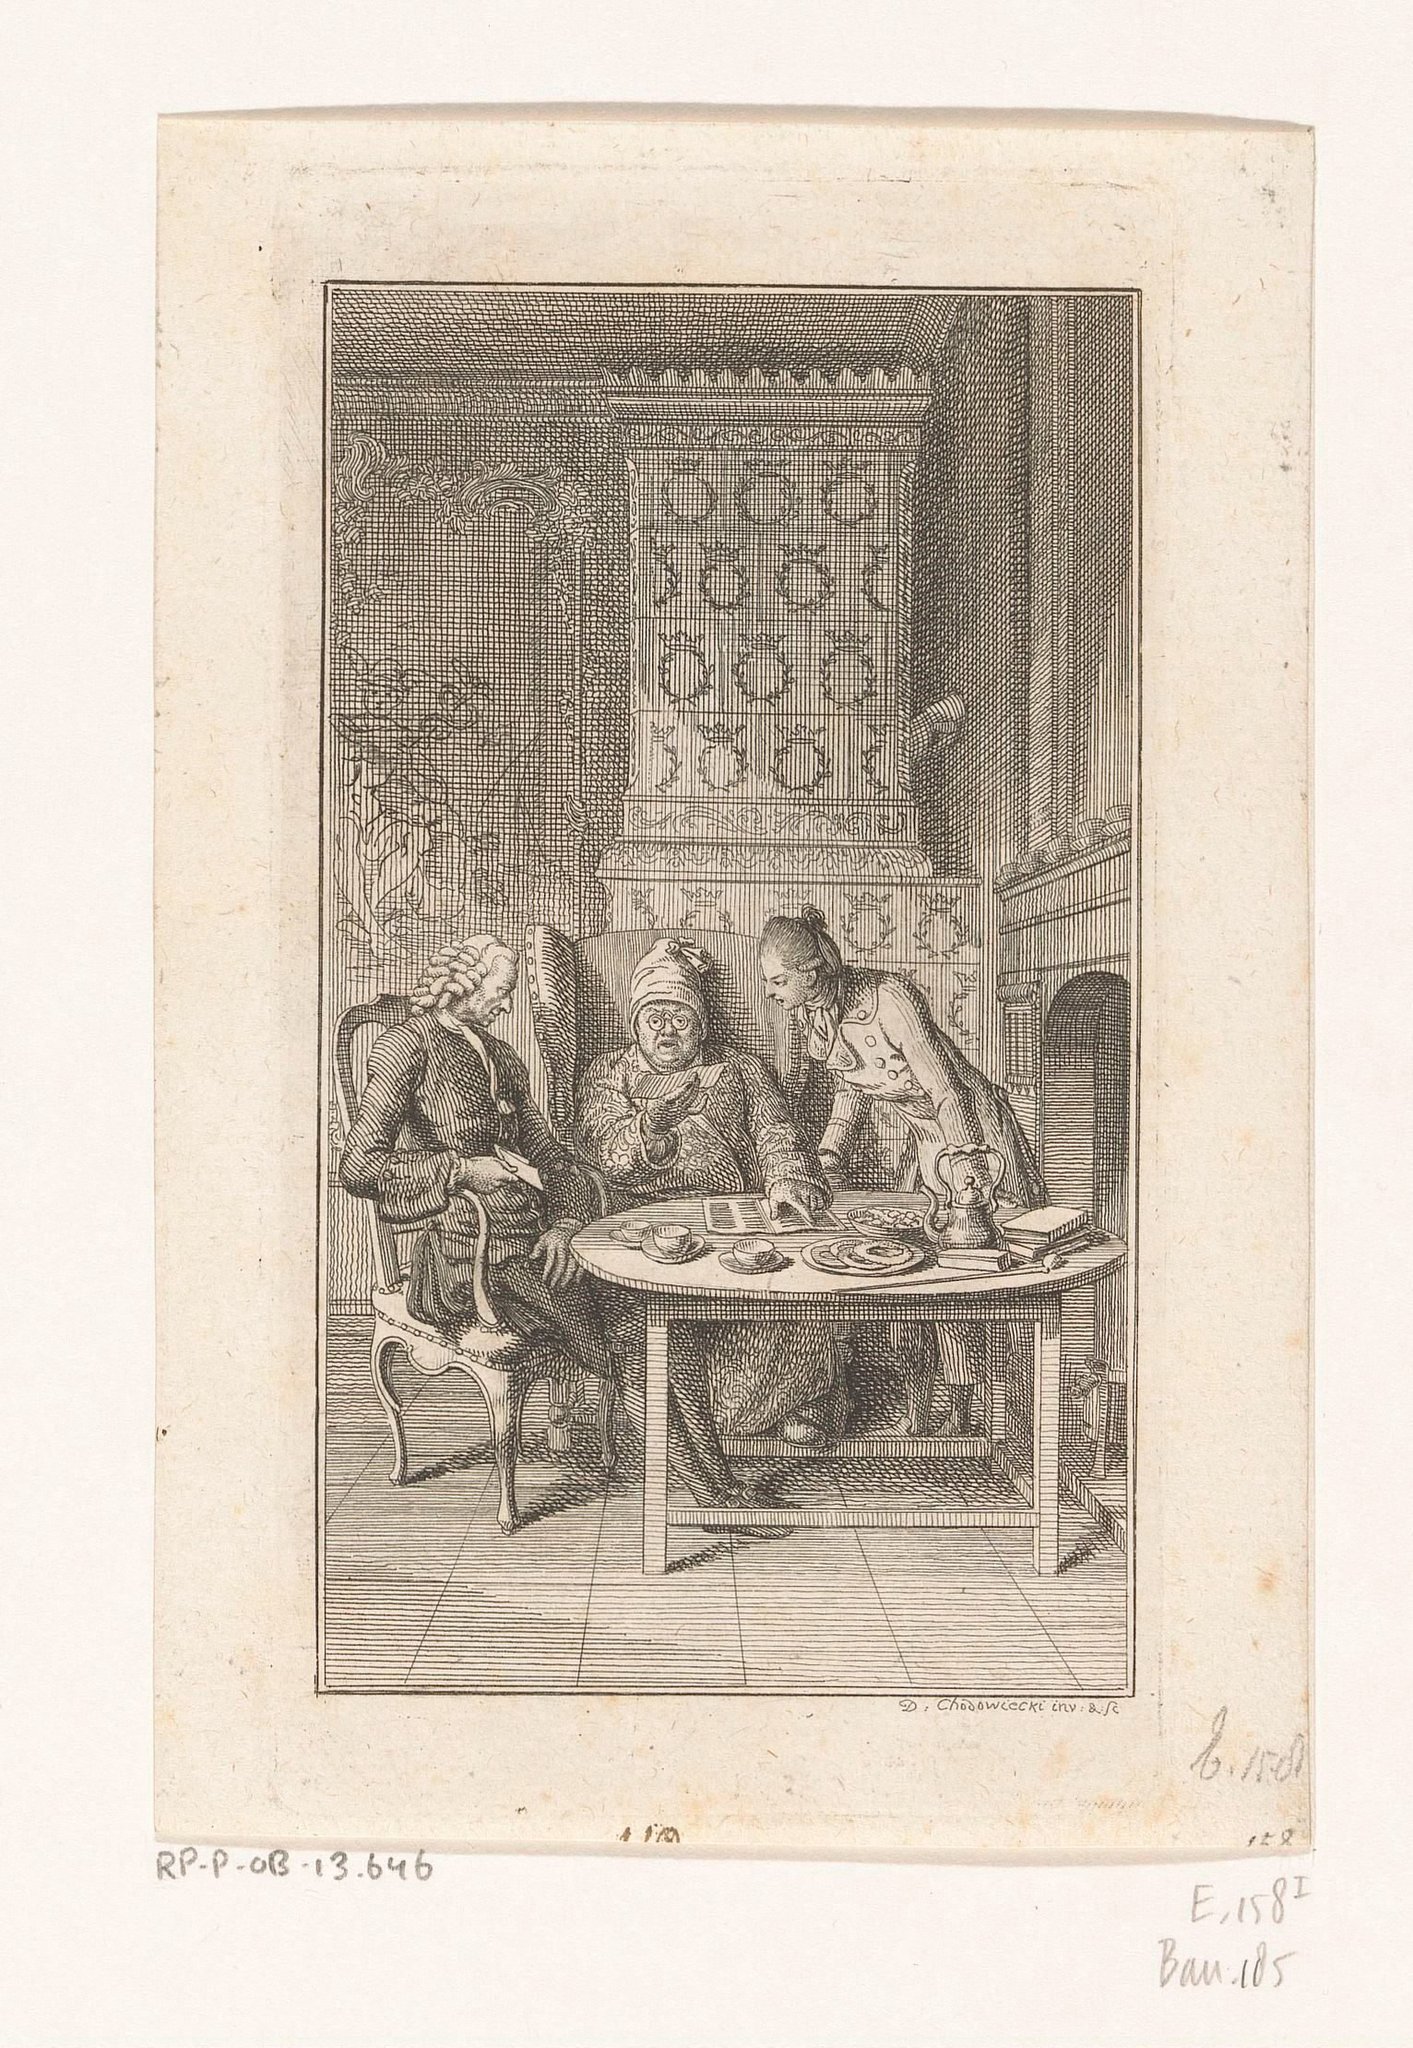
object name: print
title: Sebaldus Nothanker wint de loterij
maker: daniel nikolaus chodowiecki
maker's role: draughtsman, print maker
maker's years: 1726-1801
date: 1776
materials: paper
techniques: etching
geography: berlin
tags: berlin, friedrich nicolai, raffle, lottery, literature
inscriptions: collector's mark: Lugt 2228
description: Voor de kachel zit de oude Säugling een leunstoel. Rechts van hem staat zijn zoon. Tijdens het voorlezen van de loterij uitslagen blijkt dat Sebaldus, in de stoel links, een klein fortuin heeft gewonnen. Hierdoor staat niets een huwelijk tussen Mariane en de jonge Säugling meer in de weg.